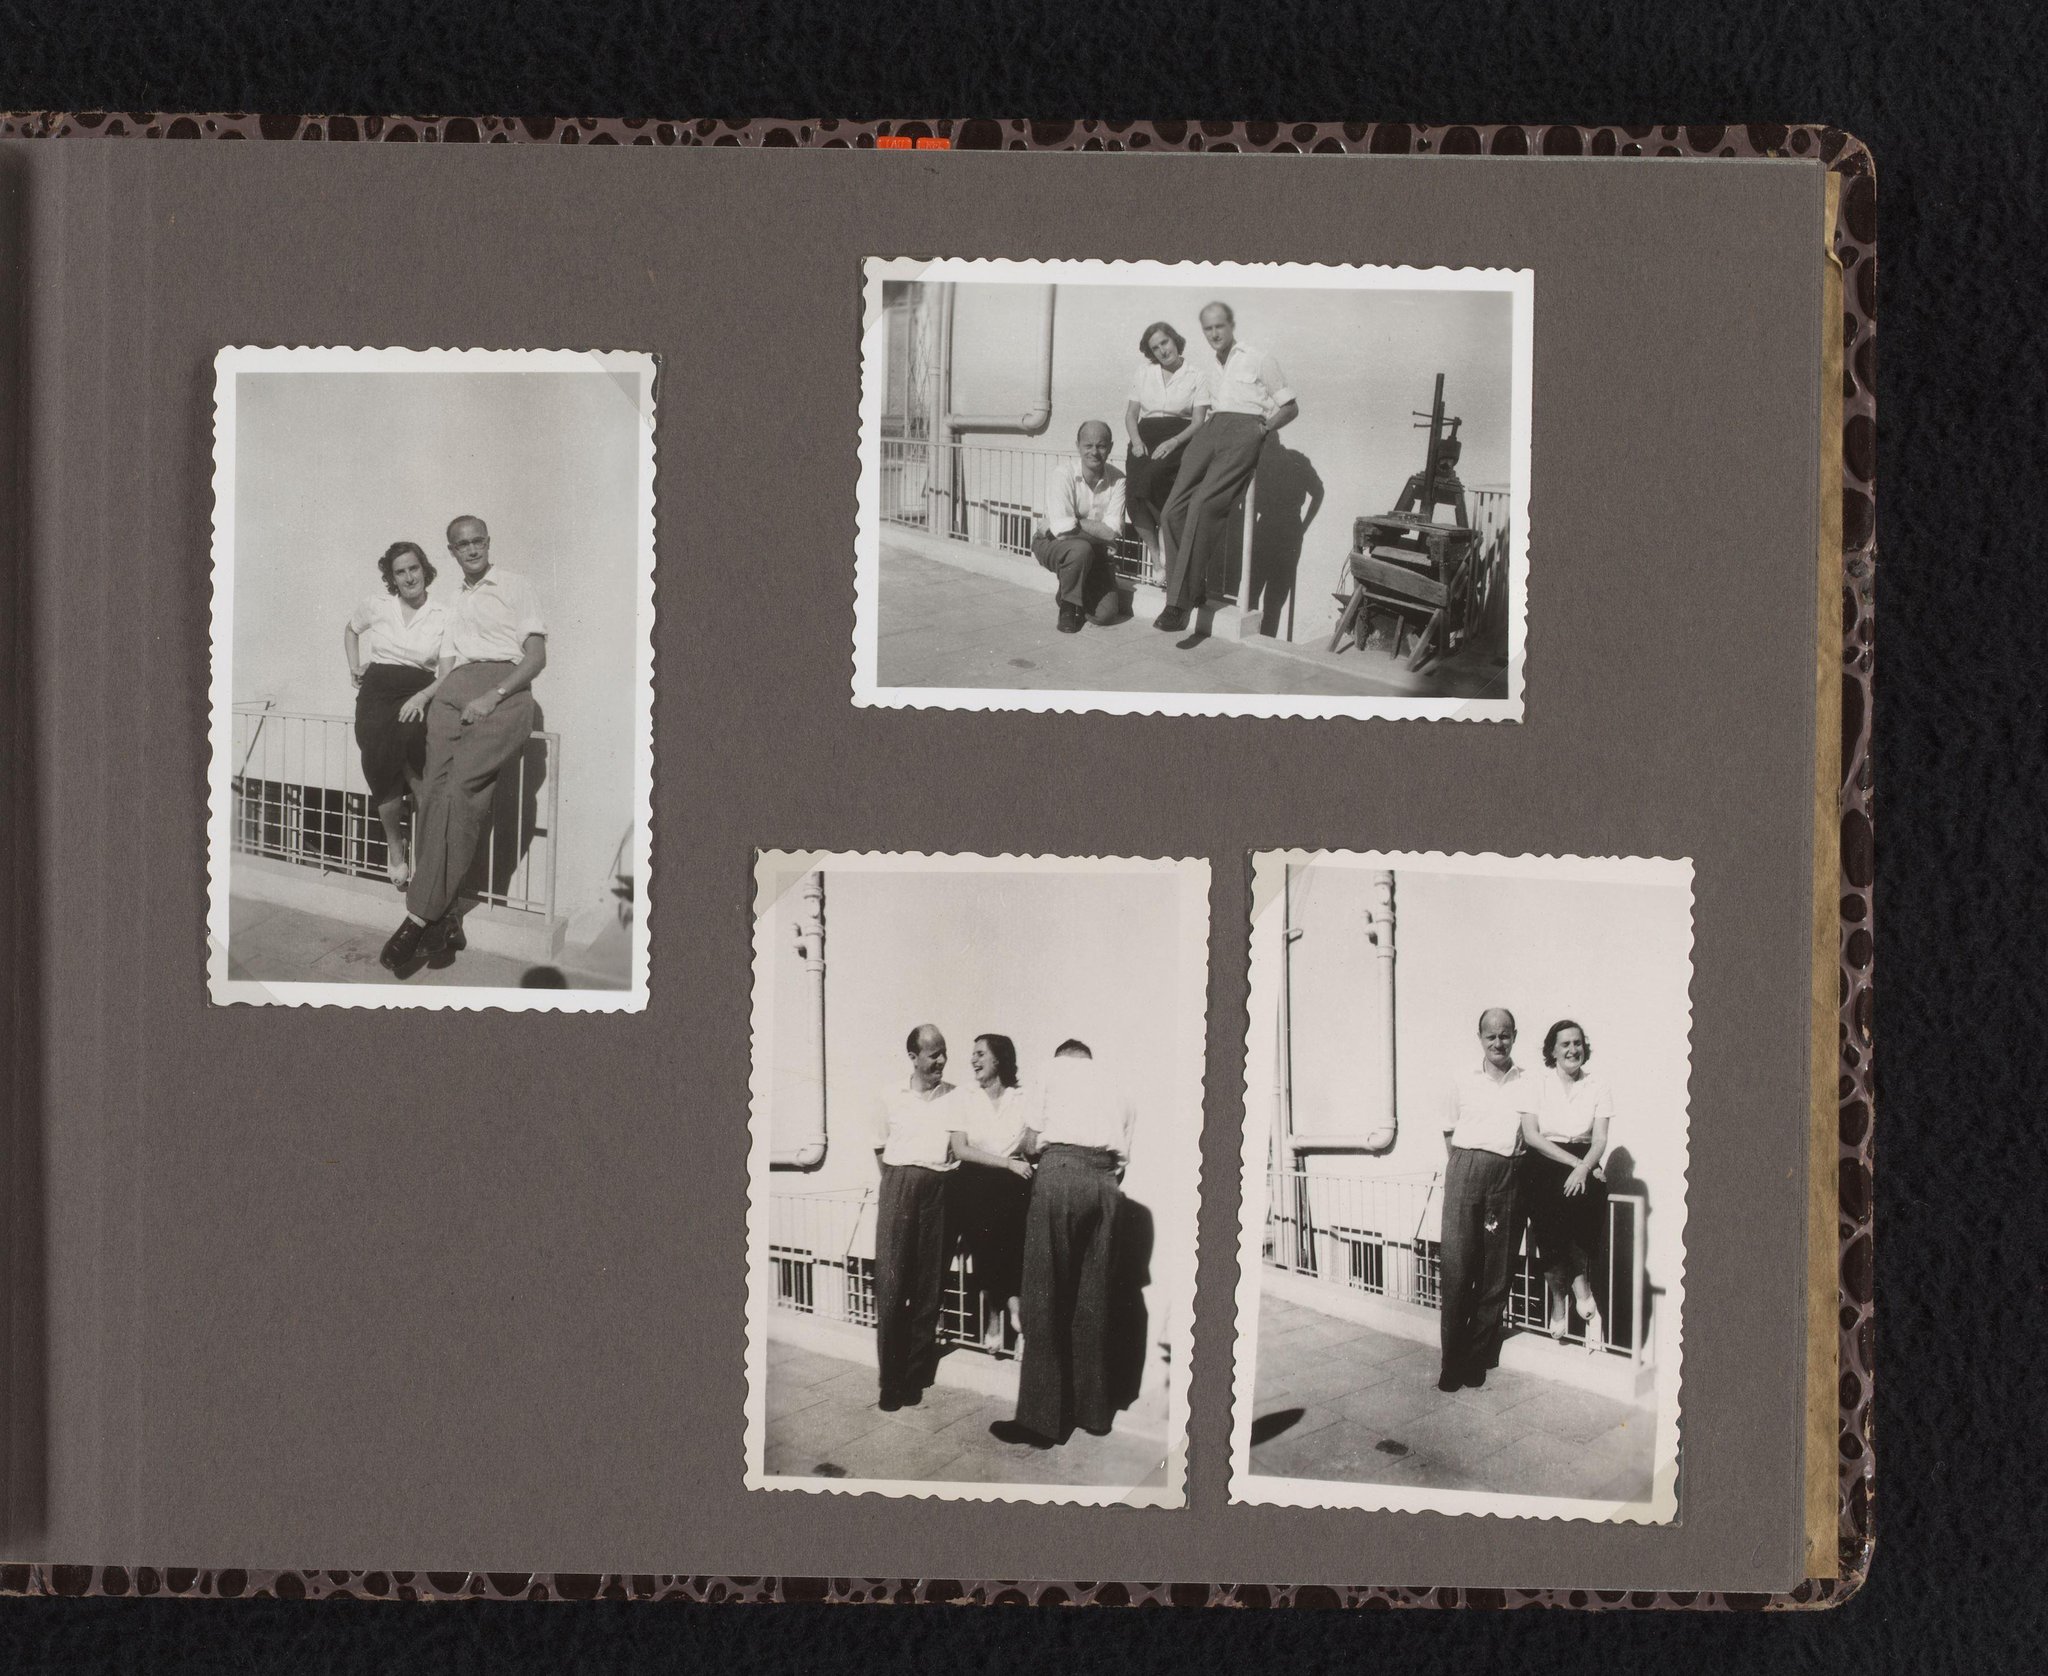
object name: photograph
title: Isabel Wachenheimer buiten met medewerkers van KLM, 1954, Israël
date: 1954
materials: cardboard, photographic support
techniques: gelatin silver print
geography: tel aviv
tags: leiden, isabel wachenheimer-elon, historical persons - bb - woman, air hostess, stewardess, steward, purser, historical persons not known by name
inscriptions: date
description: Blad bevat vier foto's van Isabel Wachenheimer (in KLM-uniform) en verschillende mannelijke collega's. Uit album half formaat, kunstlederen omslag met koordbinding.